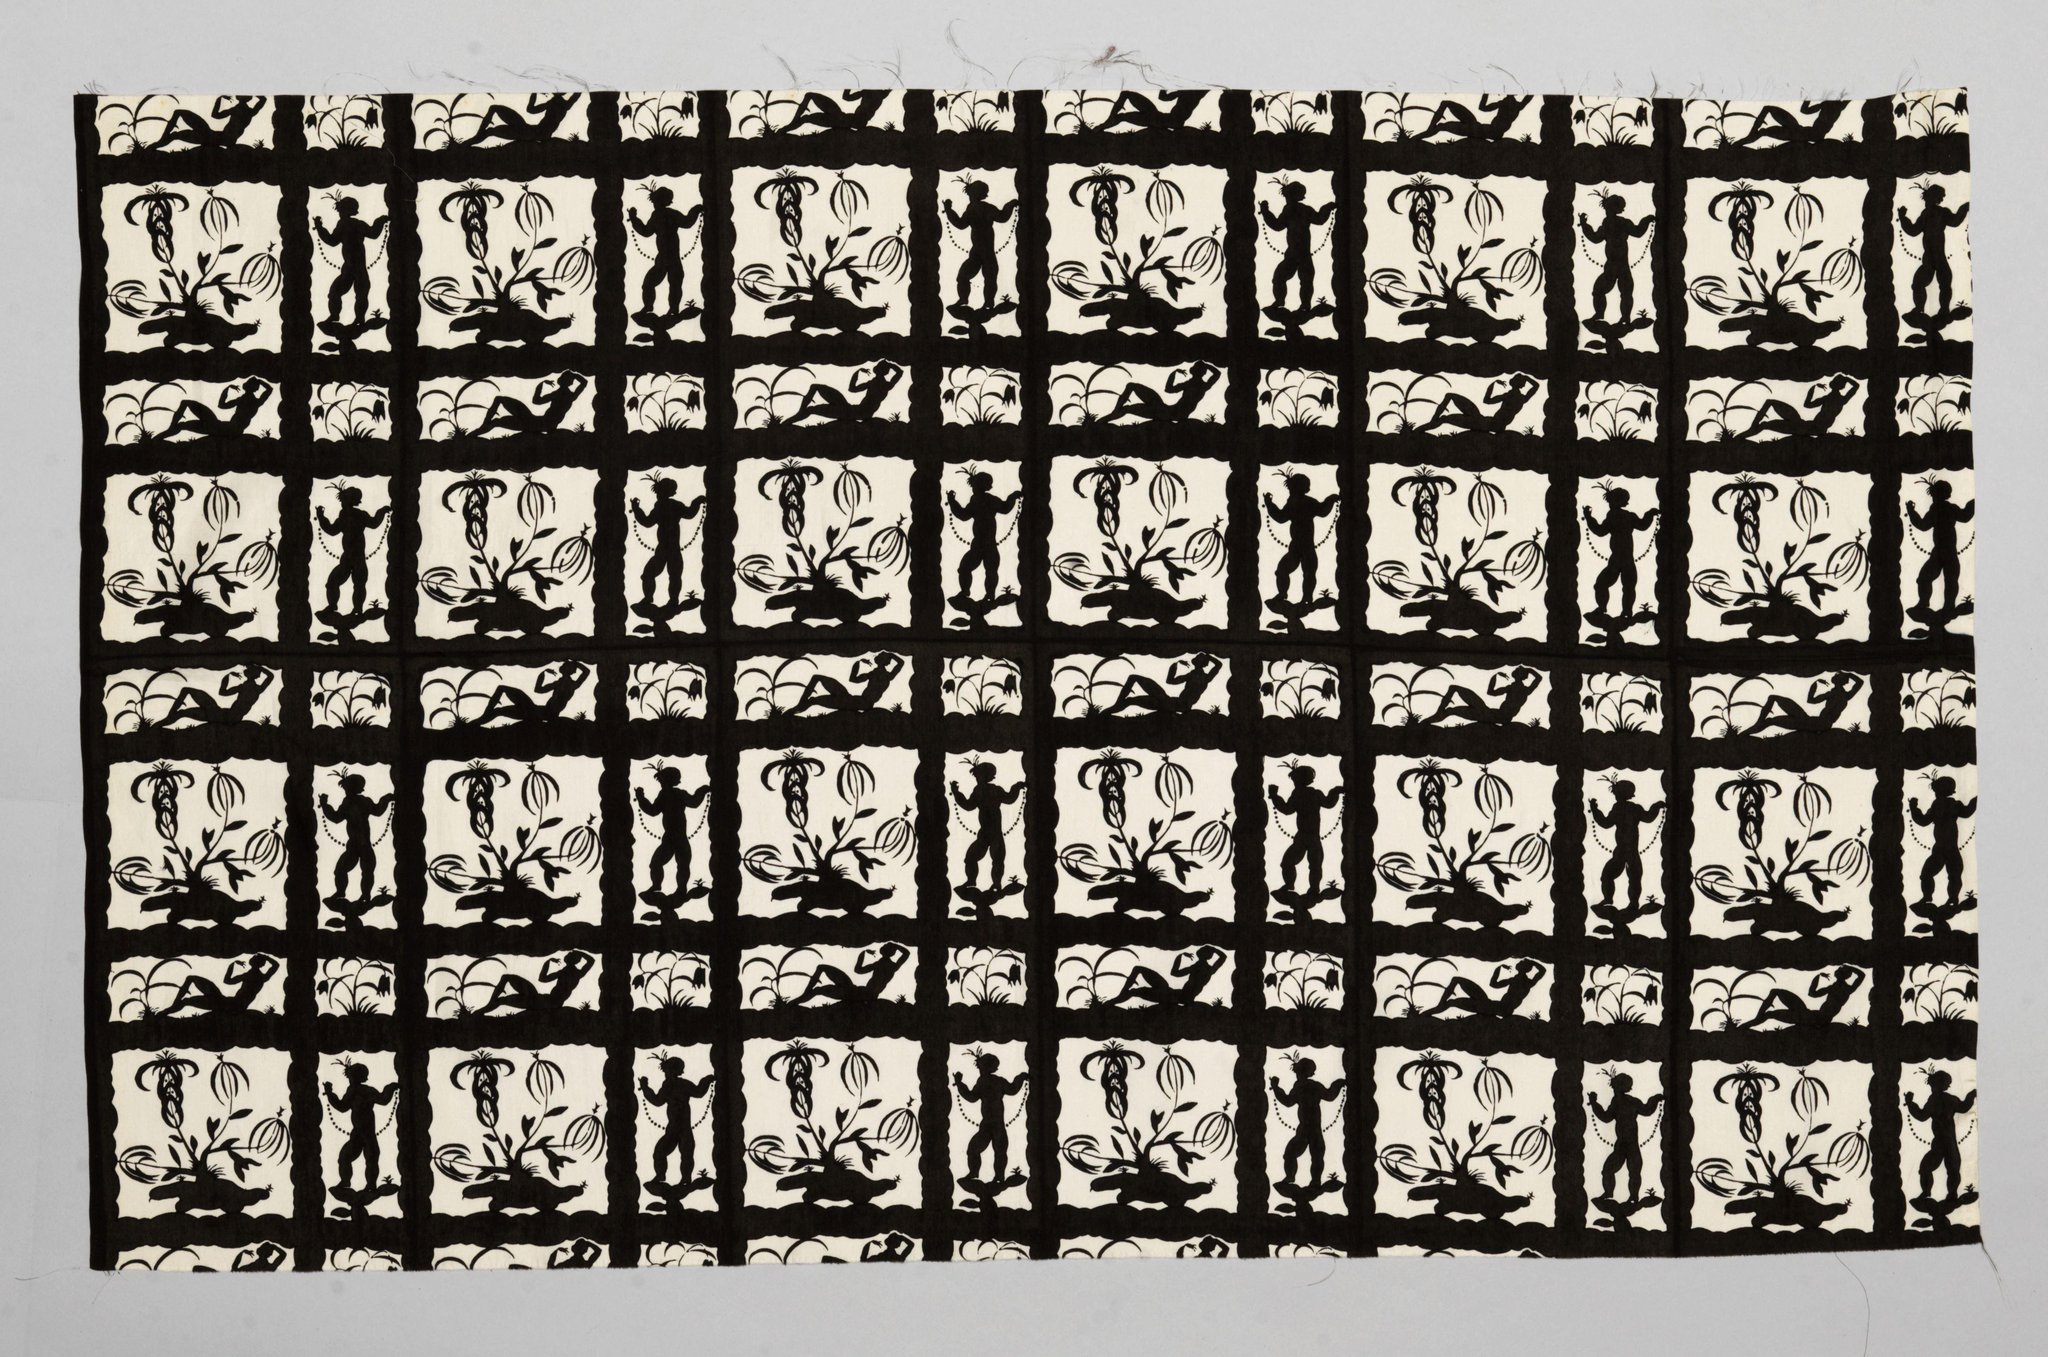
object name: coupon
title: Coupon zwart bedrukte zijde met silhouetten van mensen en planten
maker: dagobert peche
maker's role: designer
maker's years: 1887-1923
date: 1916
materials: silk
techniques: printing block, weave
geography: vienna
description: Coupon zwart bedrukte zijde met silhouetten van mensen en planten, dessin 'Schatten'.